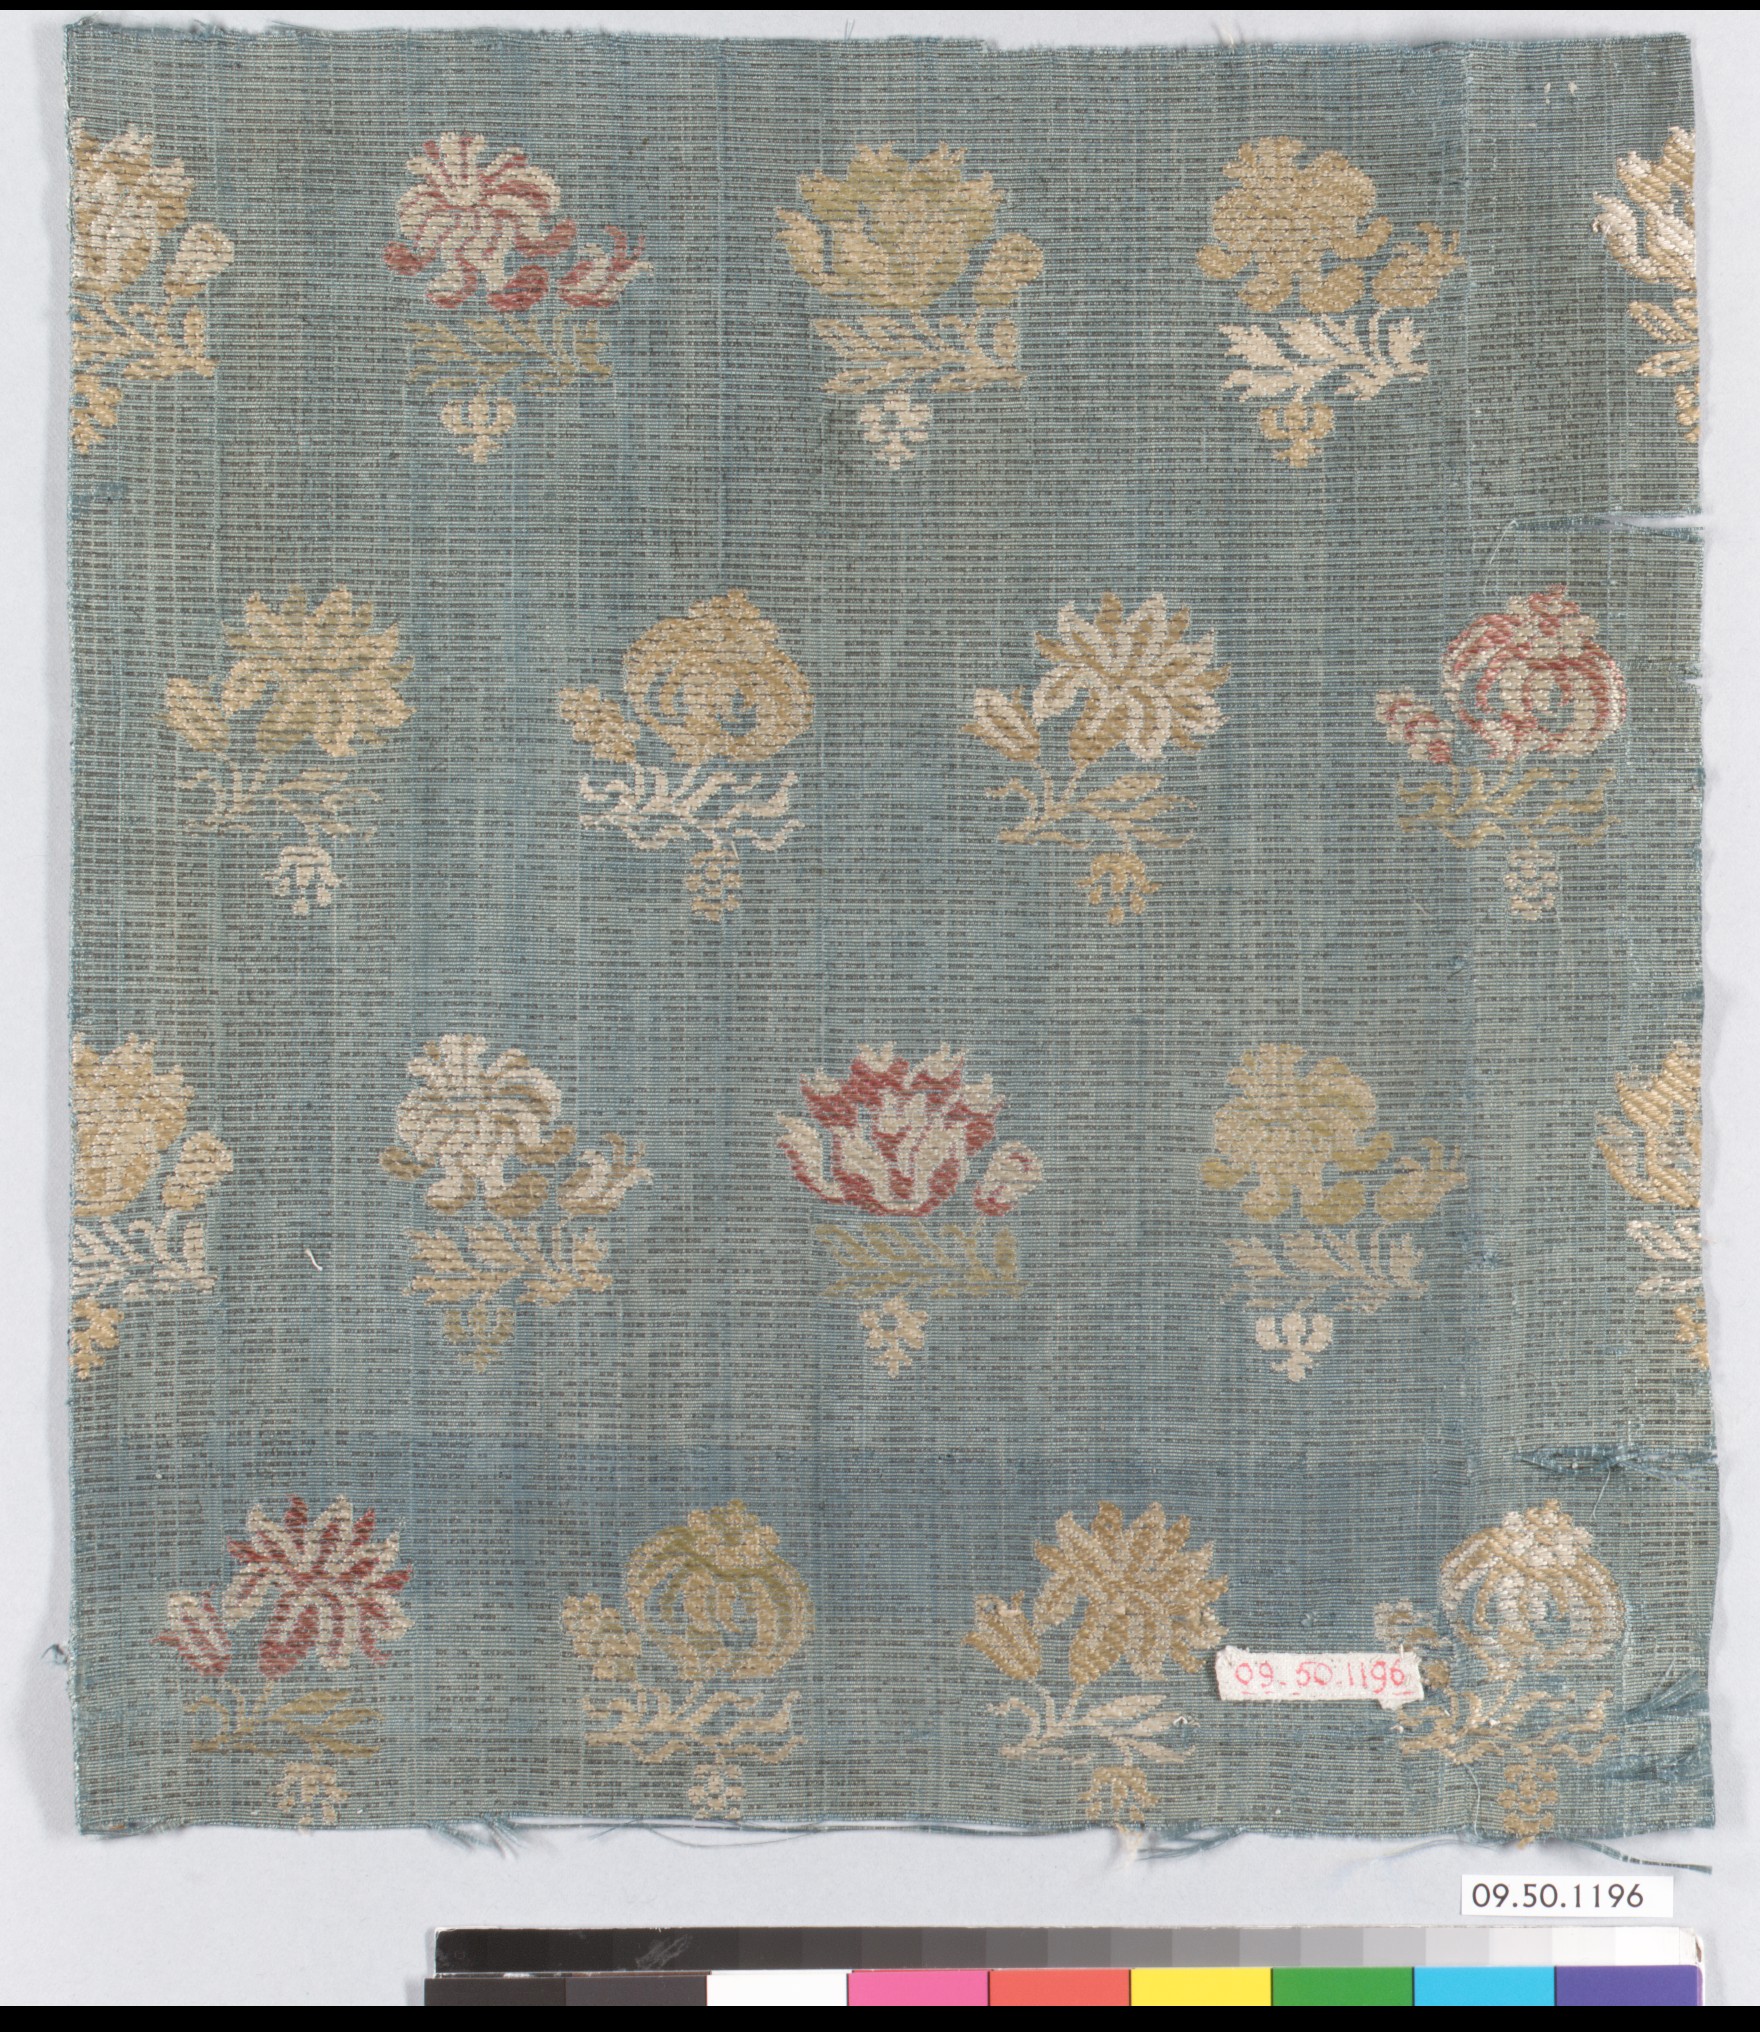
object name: piece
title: Woven silk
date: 1634-1666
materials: metal thread, silk